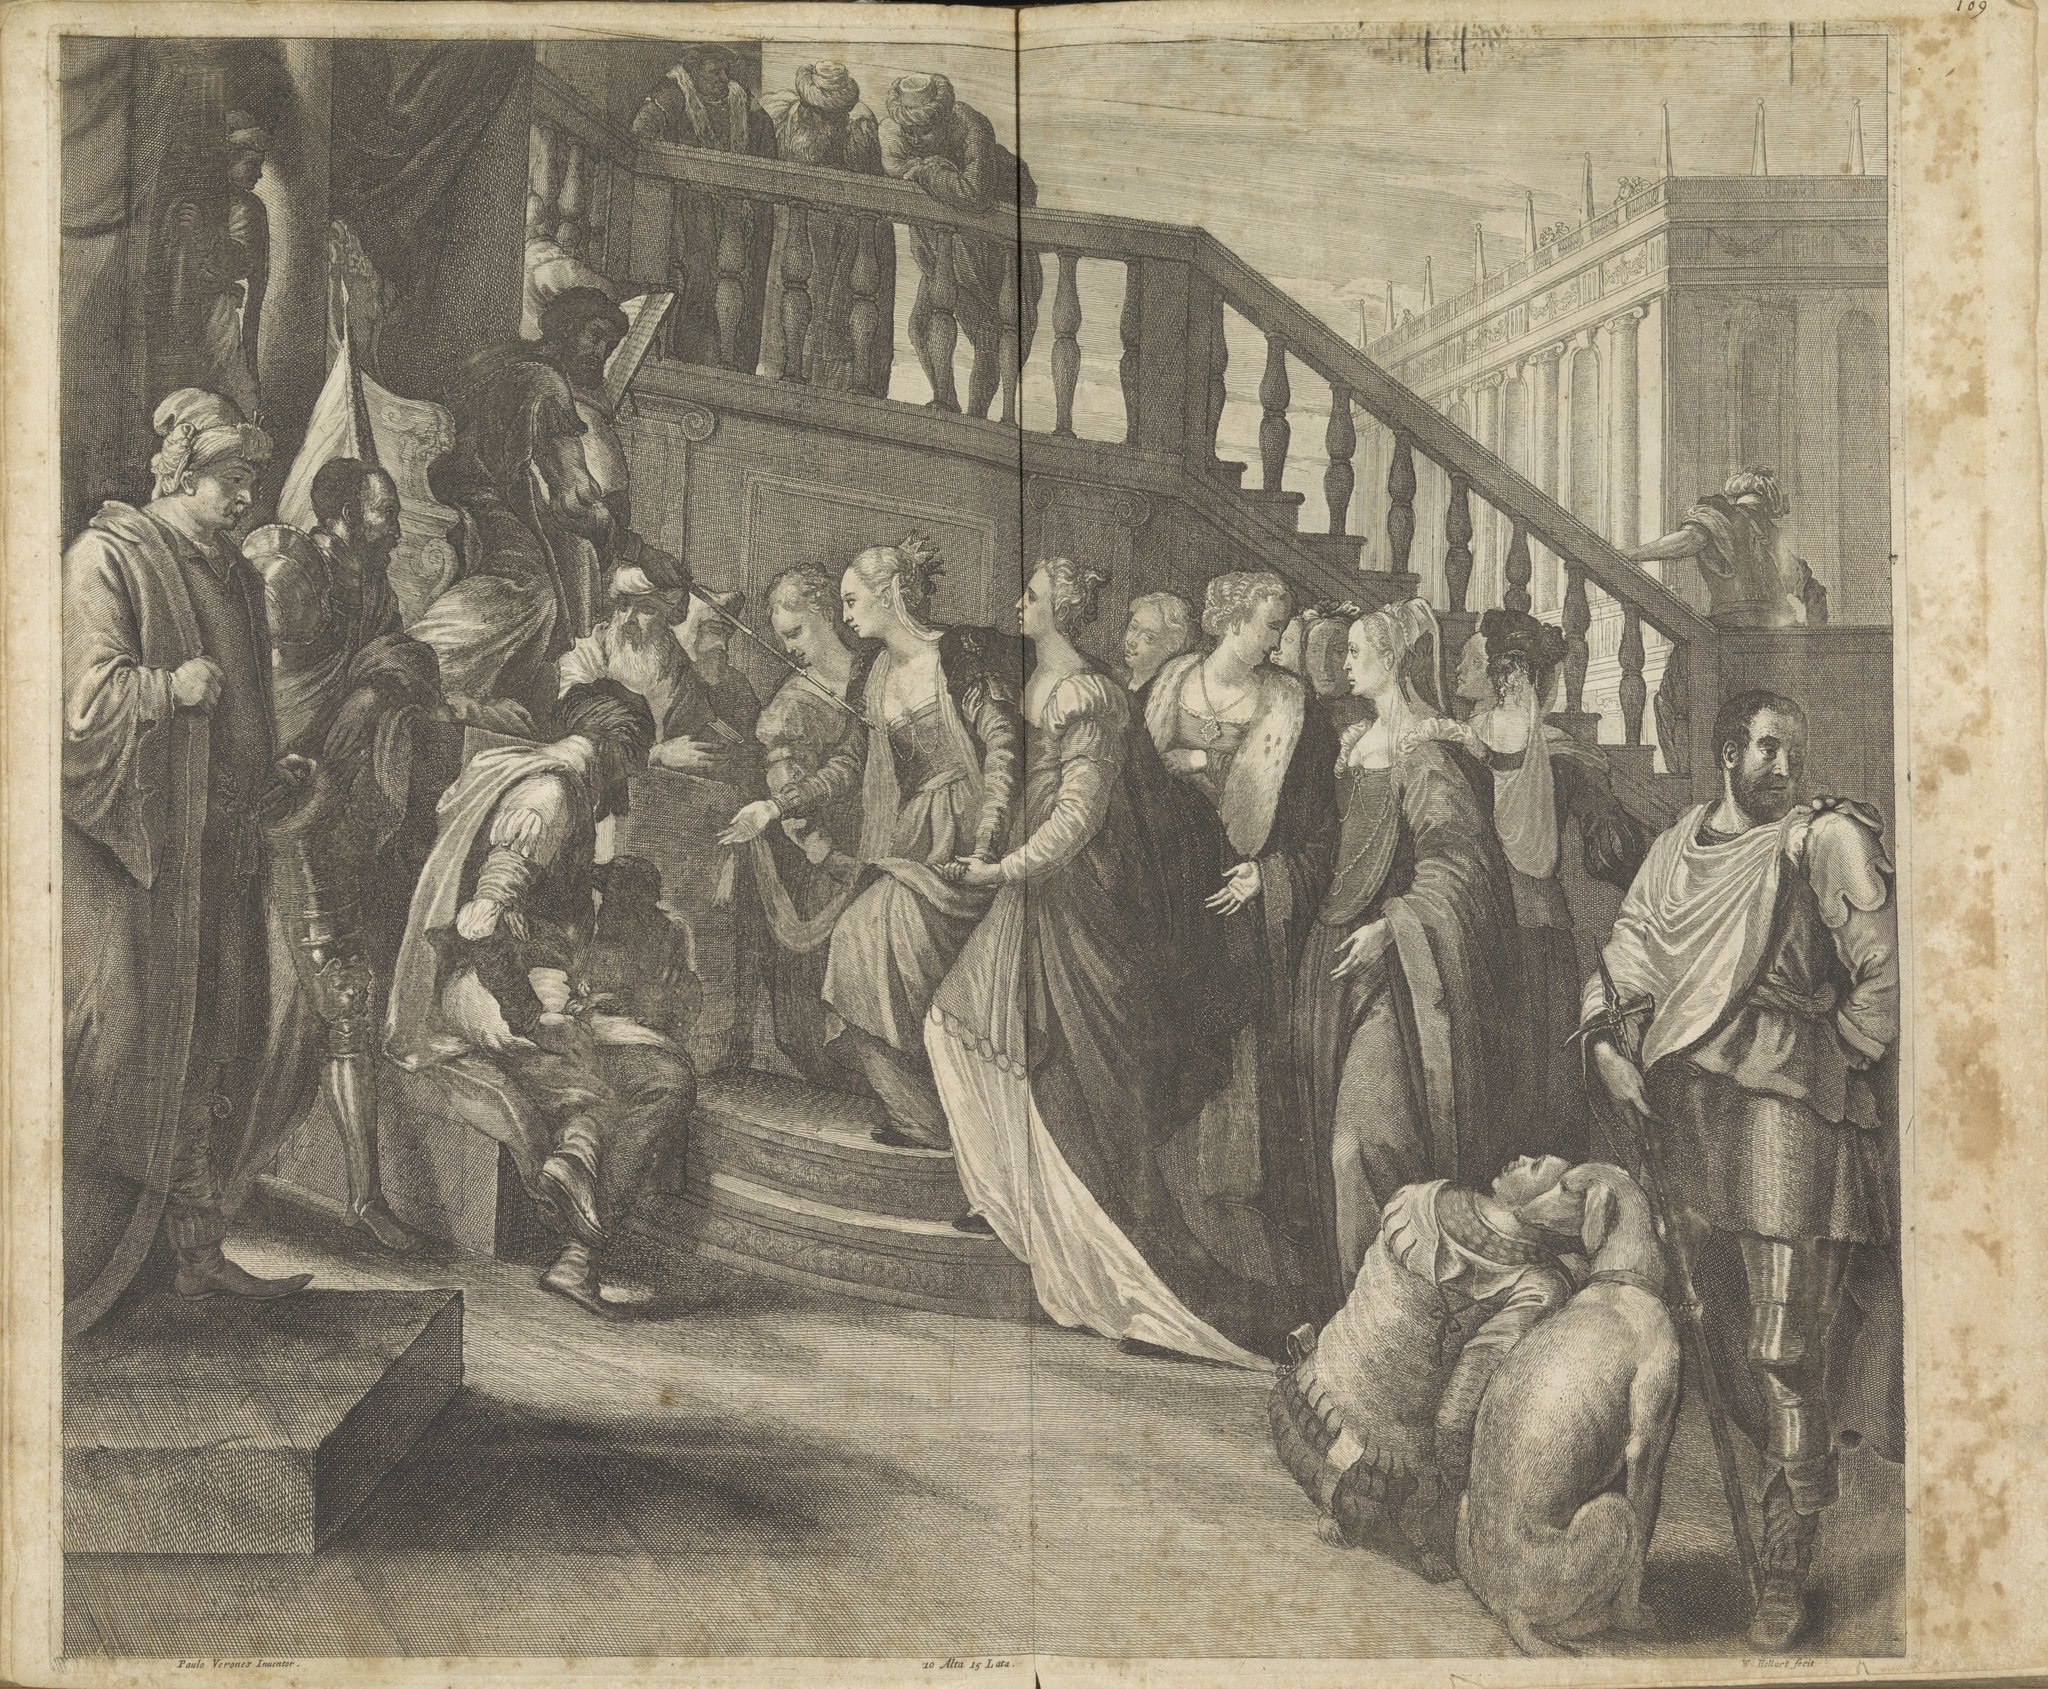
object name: print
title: Ester voor Ahasveros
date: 1660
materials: paper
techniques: etching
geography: brussels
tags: ahasuerus holds out his sceptre to esther (esther usually kneeling)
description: David Teniers heeft waarschijnlijk van alle schilderijen uit de collectie van Leopold Willem van Oostenrijk een olieverfstudie op doek of paneel vervaardigd (zgn. pasticcio), die als voorbeeld voor de prentmakers diende. Het is niet altijd duidelijk of de pasticci door hem zijn gemaakt of door zijn atelier. Niet alle pasticci zijn overgeleverd.